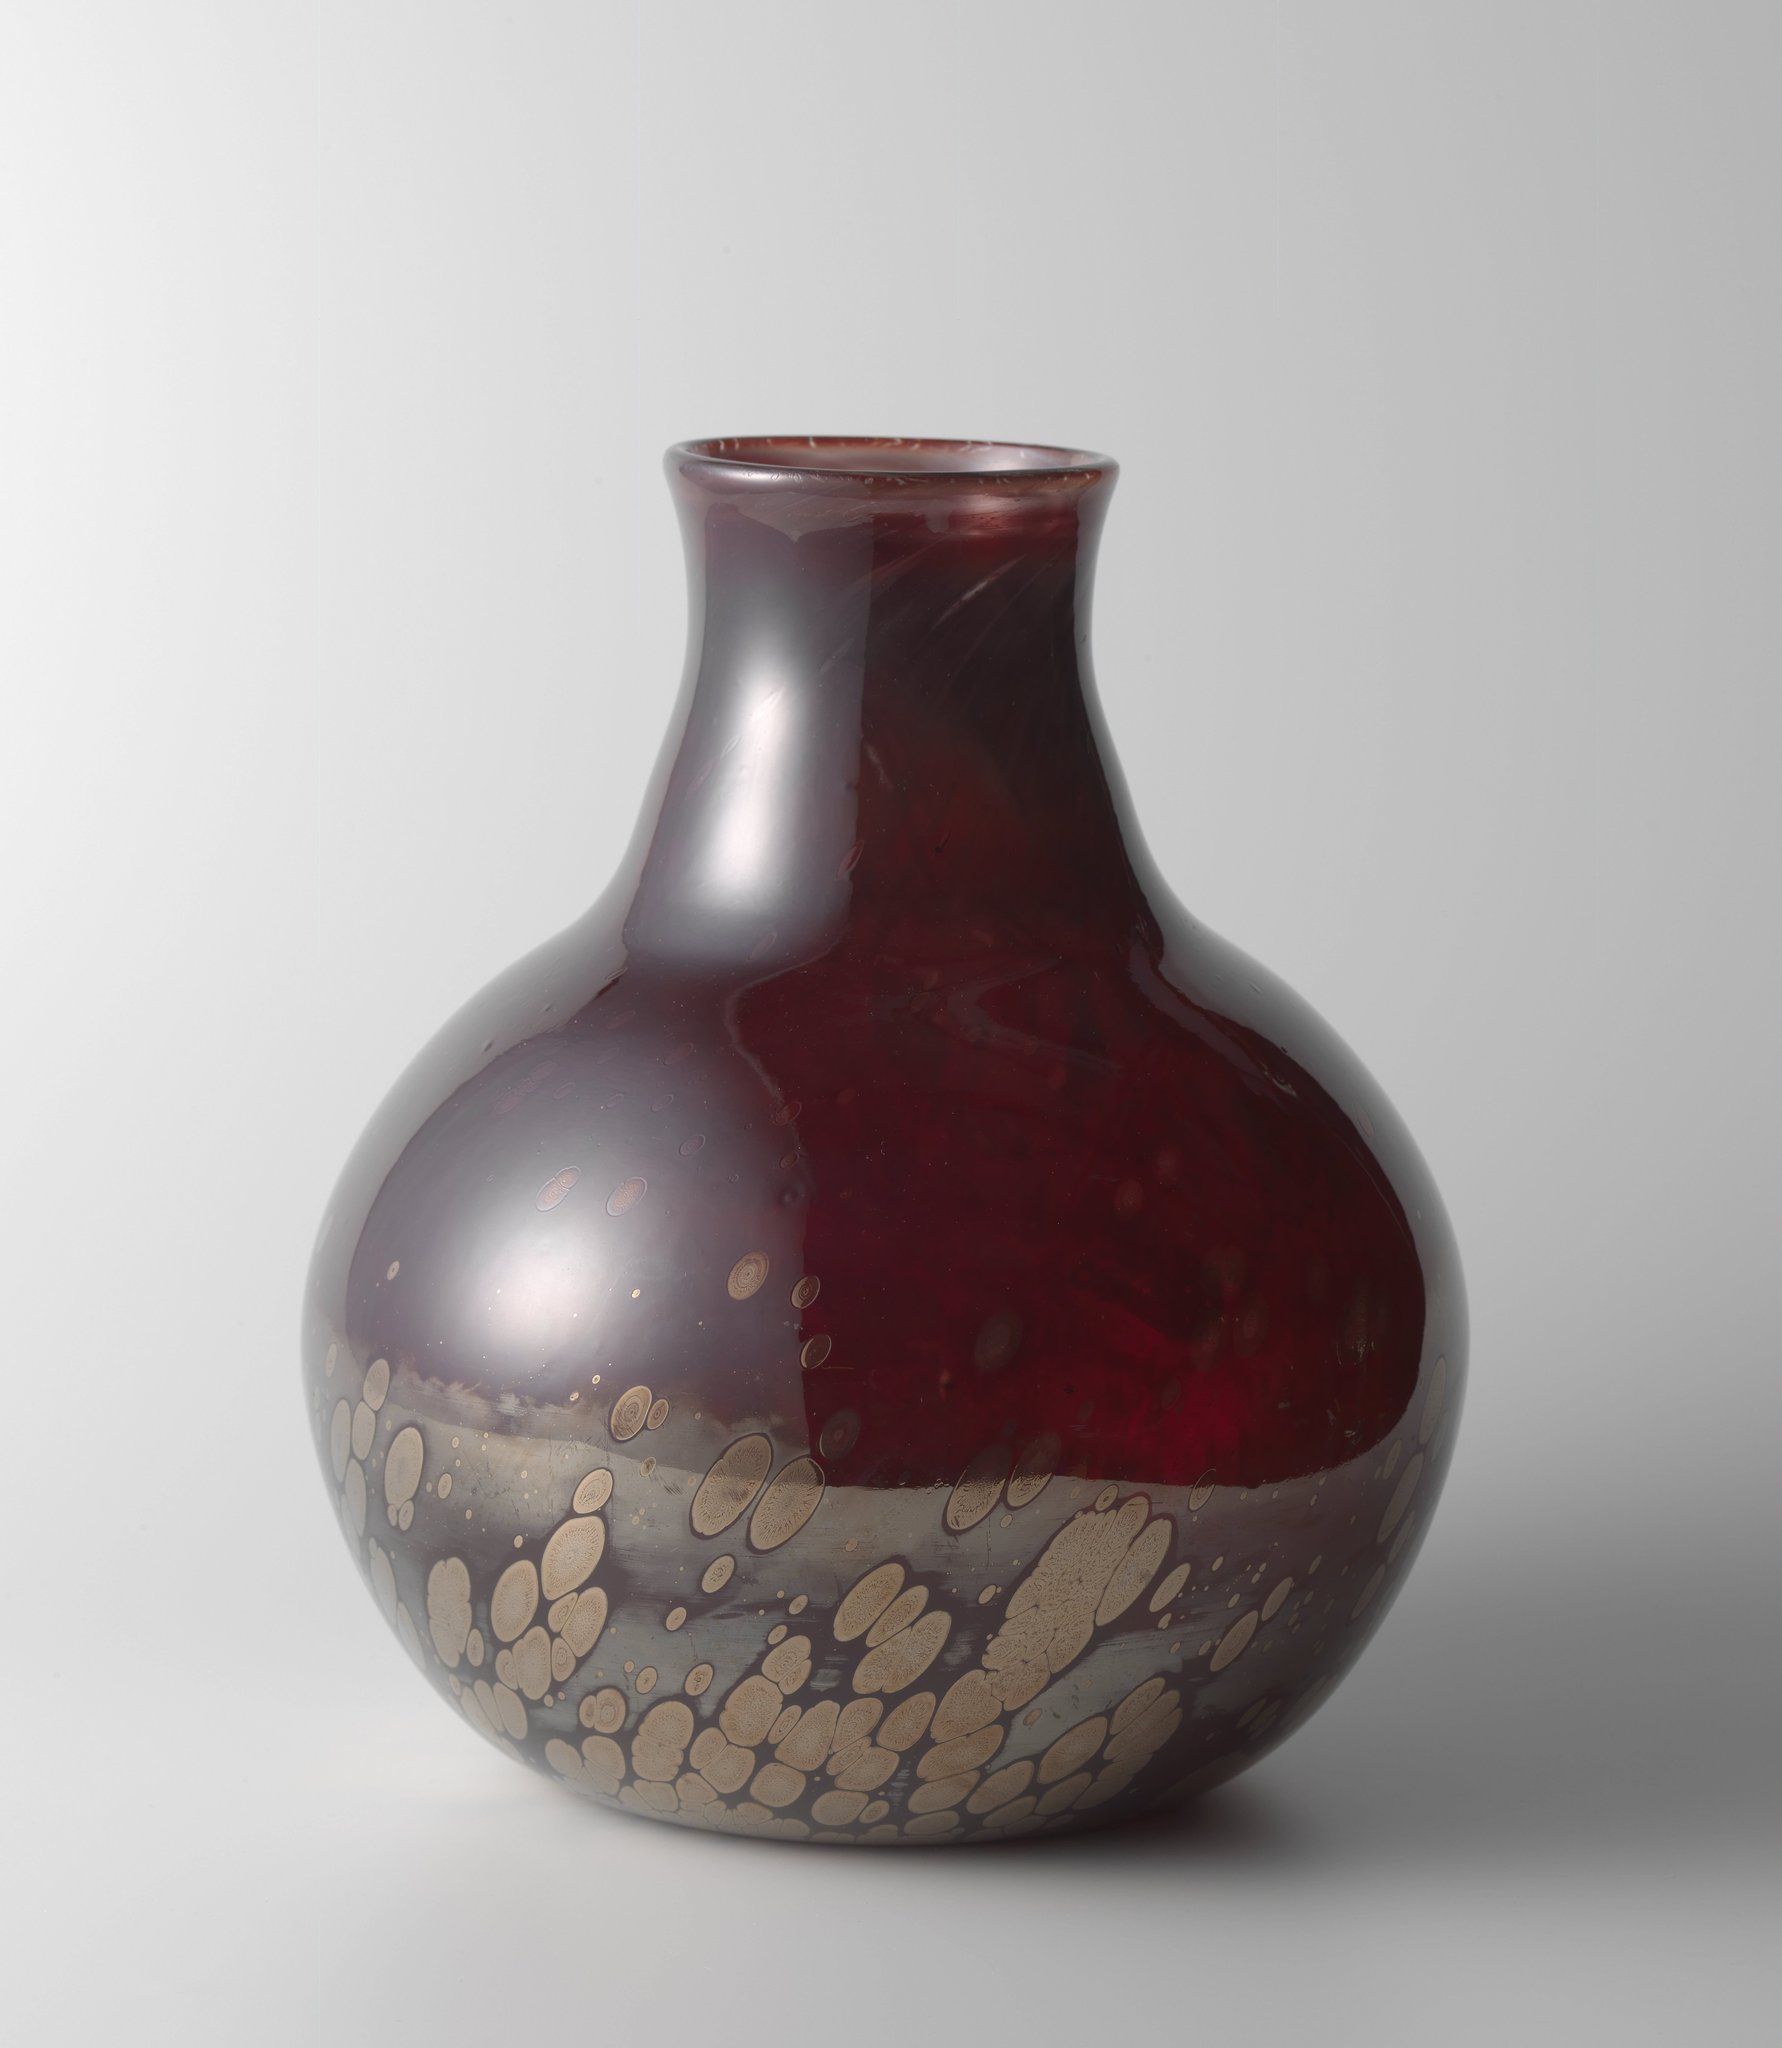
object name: vase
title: Vaas met ossenbloedrode Überfang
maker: chris lanooy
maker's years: 1881-1948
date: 1928-1929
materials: glass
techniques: glassblowing, iridescence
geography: leerdam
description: Licht ingestoken bodem. Bolvormig lichaam overgaande in een korte hals, vrijgeblazen en gevormd. Ossebloedrode Überfang, in een reducerend vuur opengebroken. De onderzijde van het lichaam geïriseerd. In de opengebroken delen een sterke goudglans. Gemerkt met de diamant Leerdam Unica C.J. Lanooy E54.